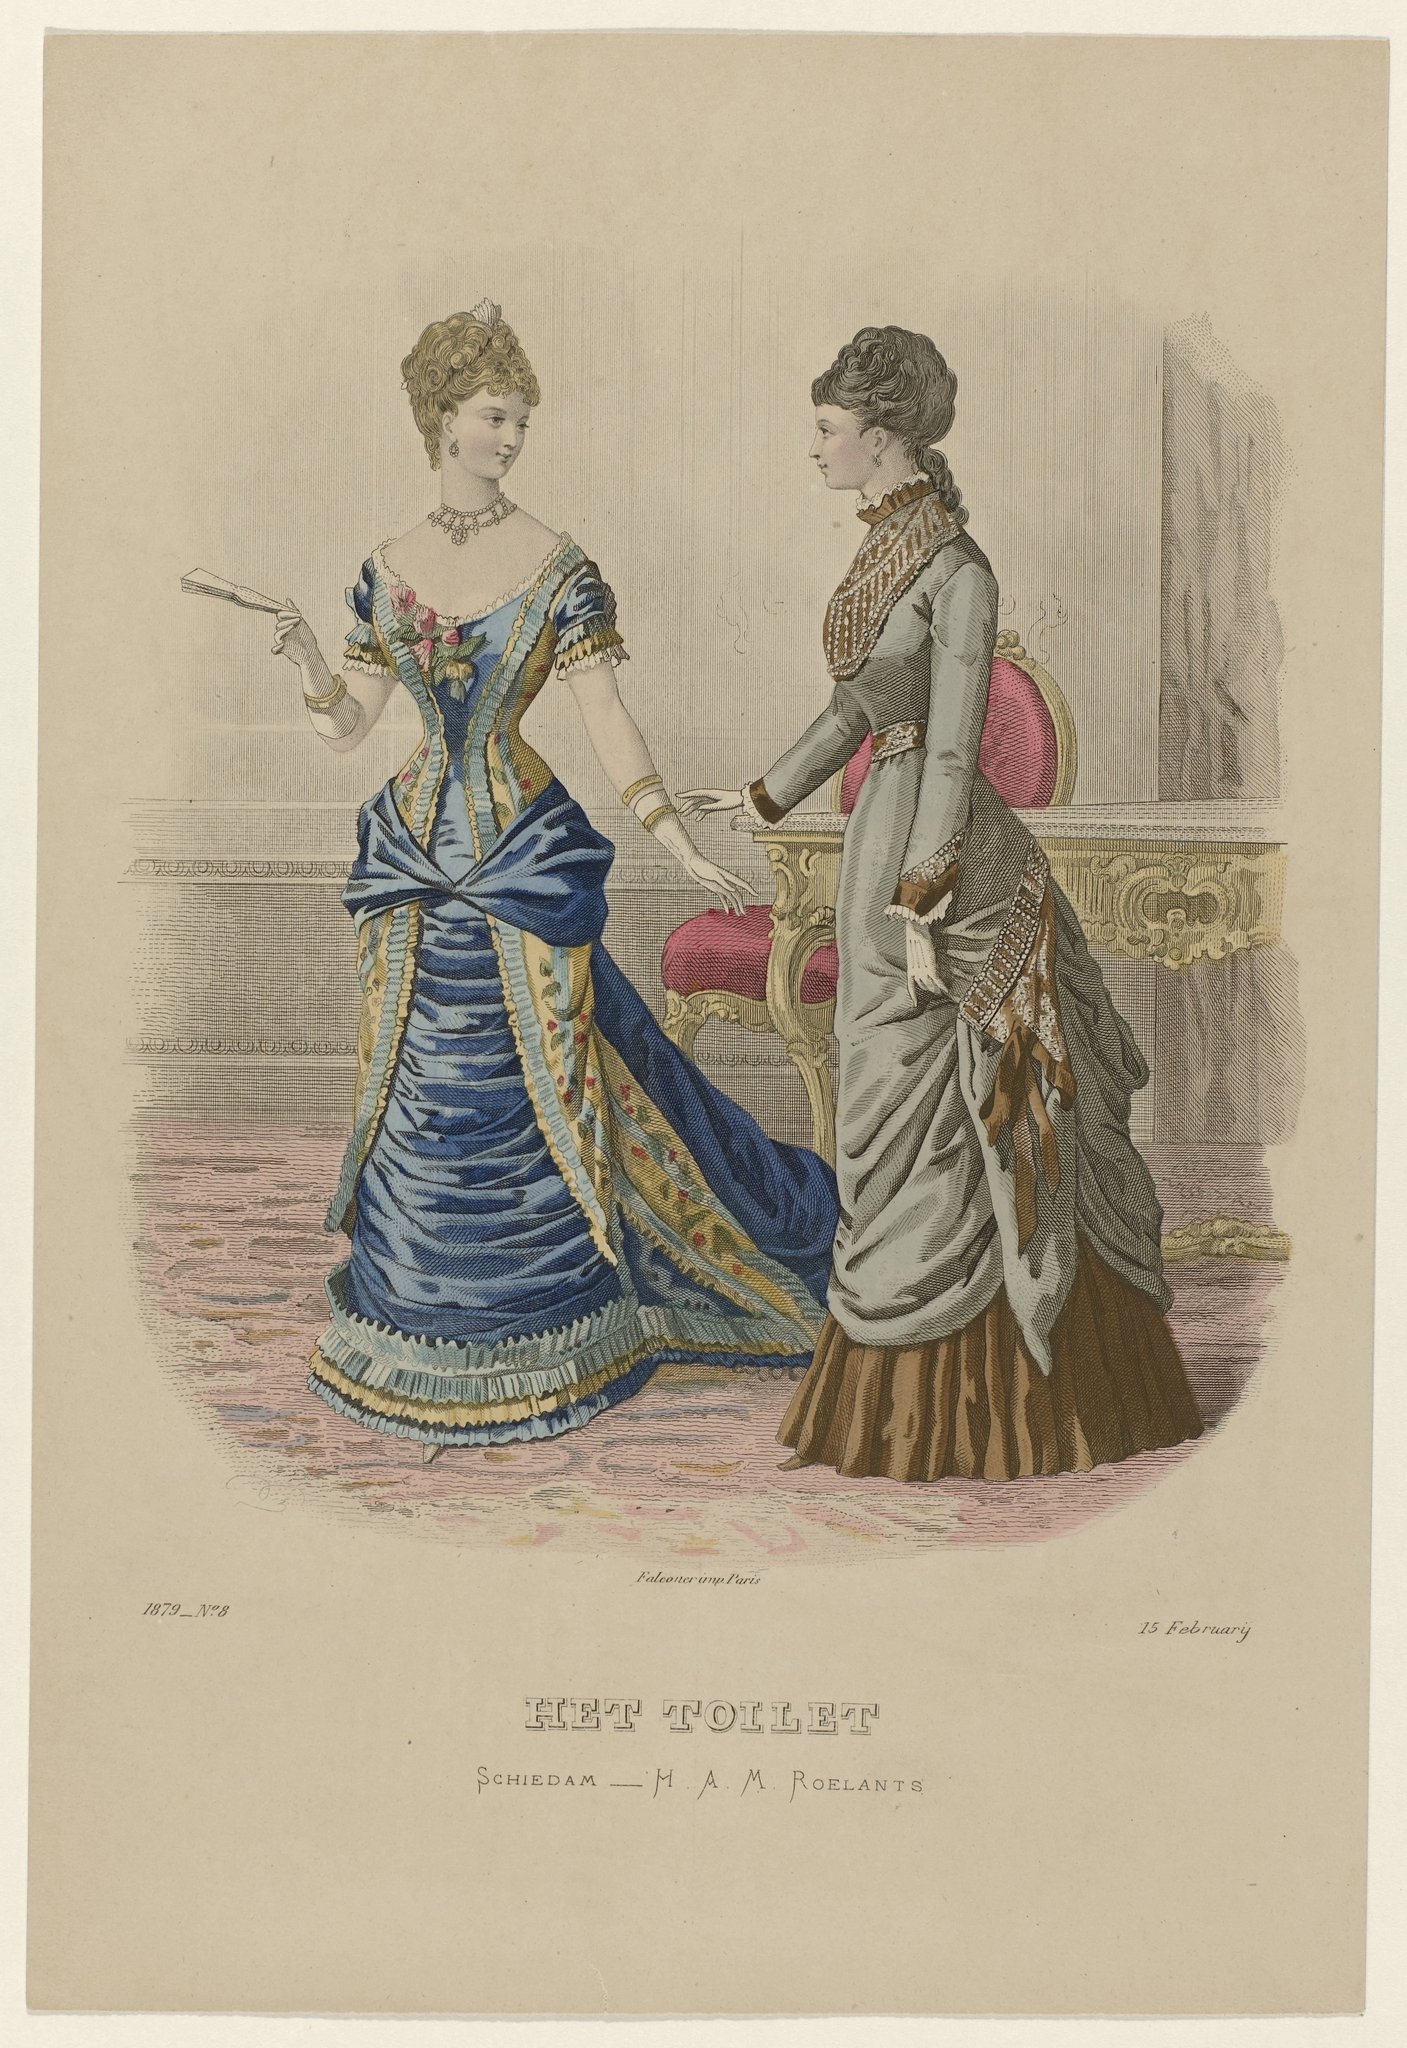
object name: fashion print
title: Het Toilet, 15 februari 1879, No. 8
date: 1879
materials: paper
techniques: engraving, hand coloring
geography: paris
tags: dress, gown: evening dress (+ women's clothes), fashion plates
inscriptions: caption: ‘HET TOILET / SCHIEDAM - H.A.M. ROELANTS’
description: Prent uit het modetijdschrift Het Toilet (1877-?).